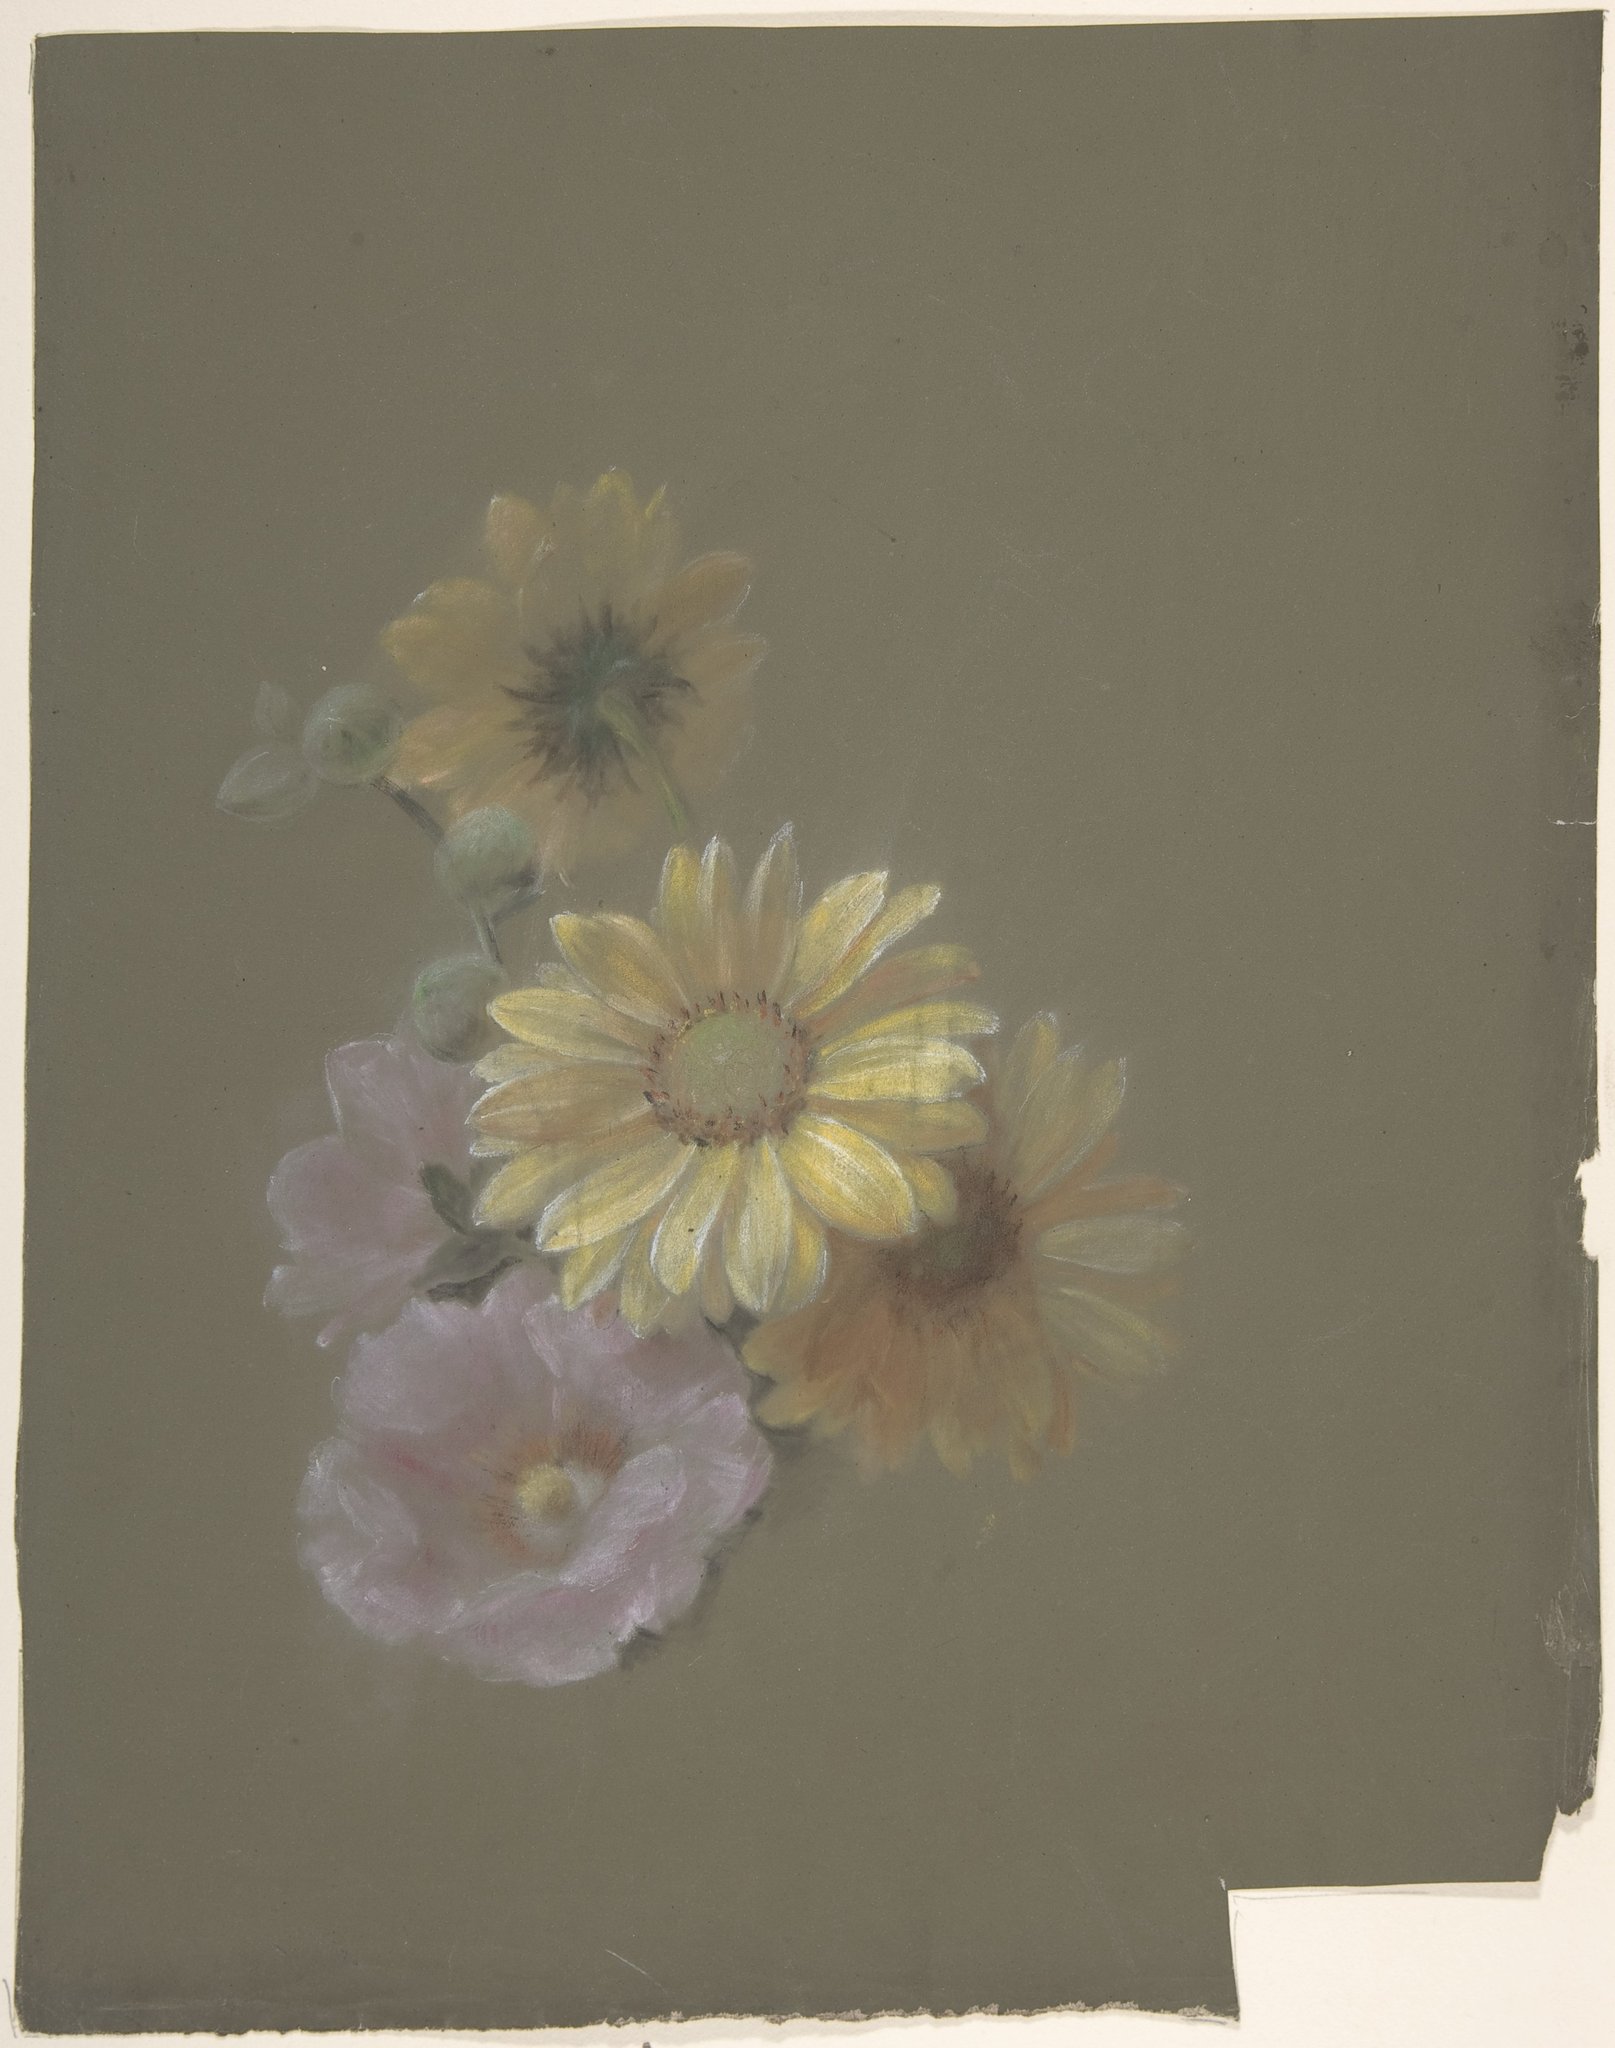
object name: drawing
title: Yellow Daisies and Pink Wild Rose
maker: antoine berjon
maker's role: artist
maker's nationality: french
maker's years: 1754-1843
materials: chalk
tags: daisies,roses